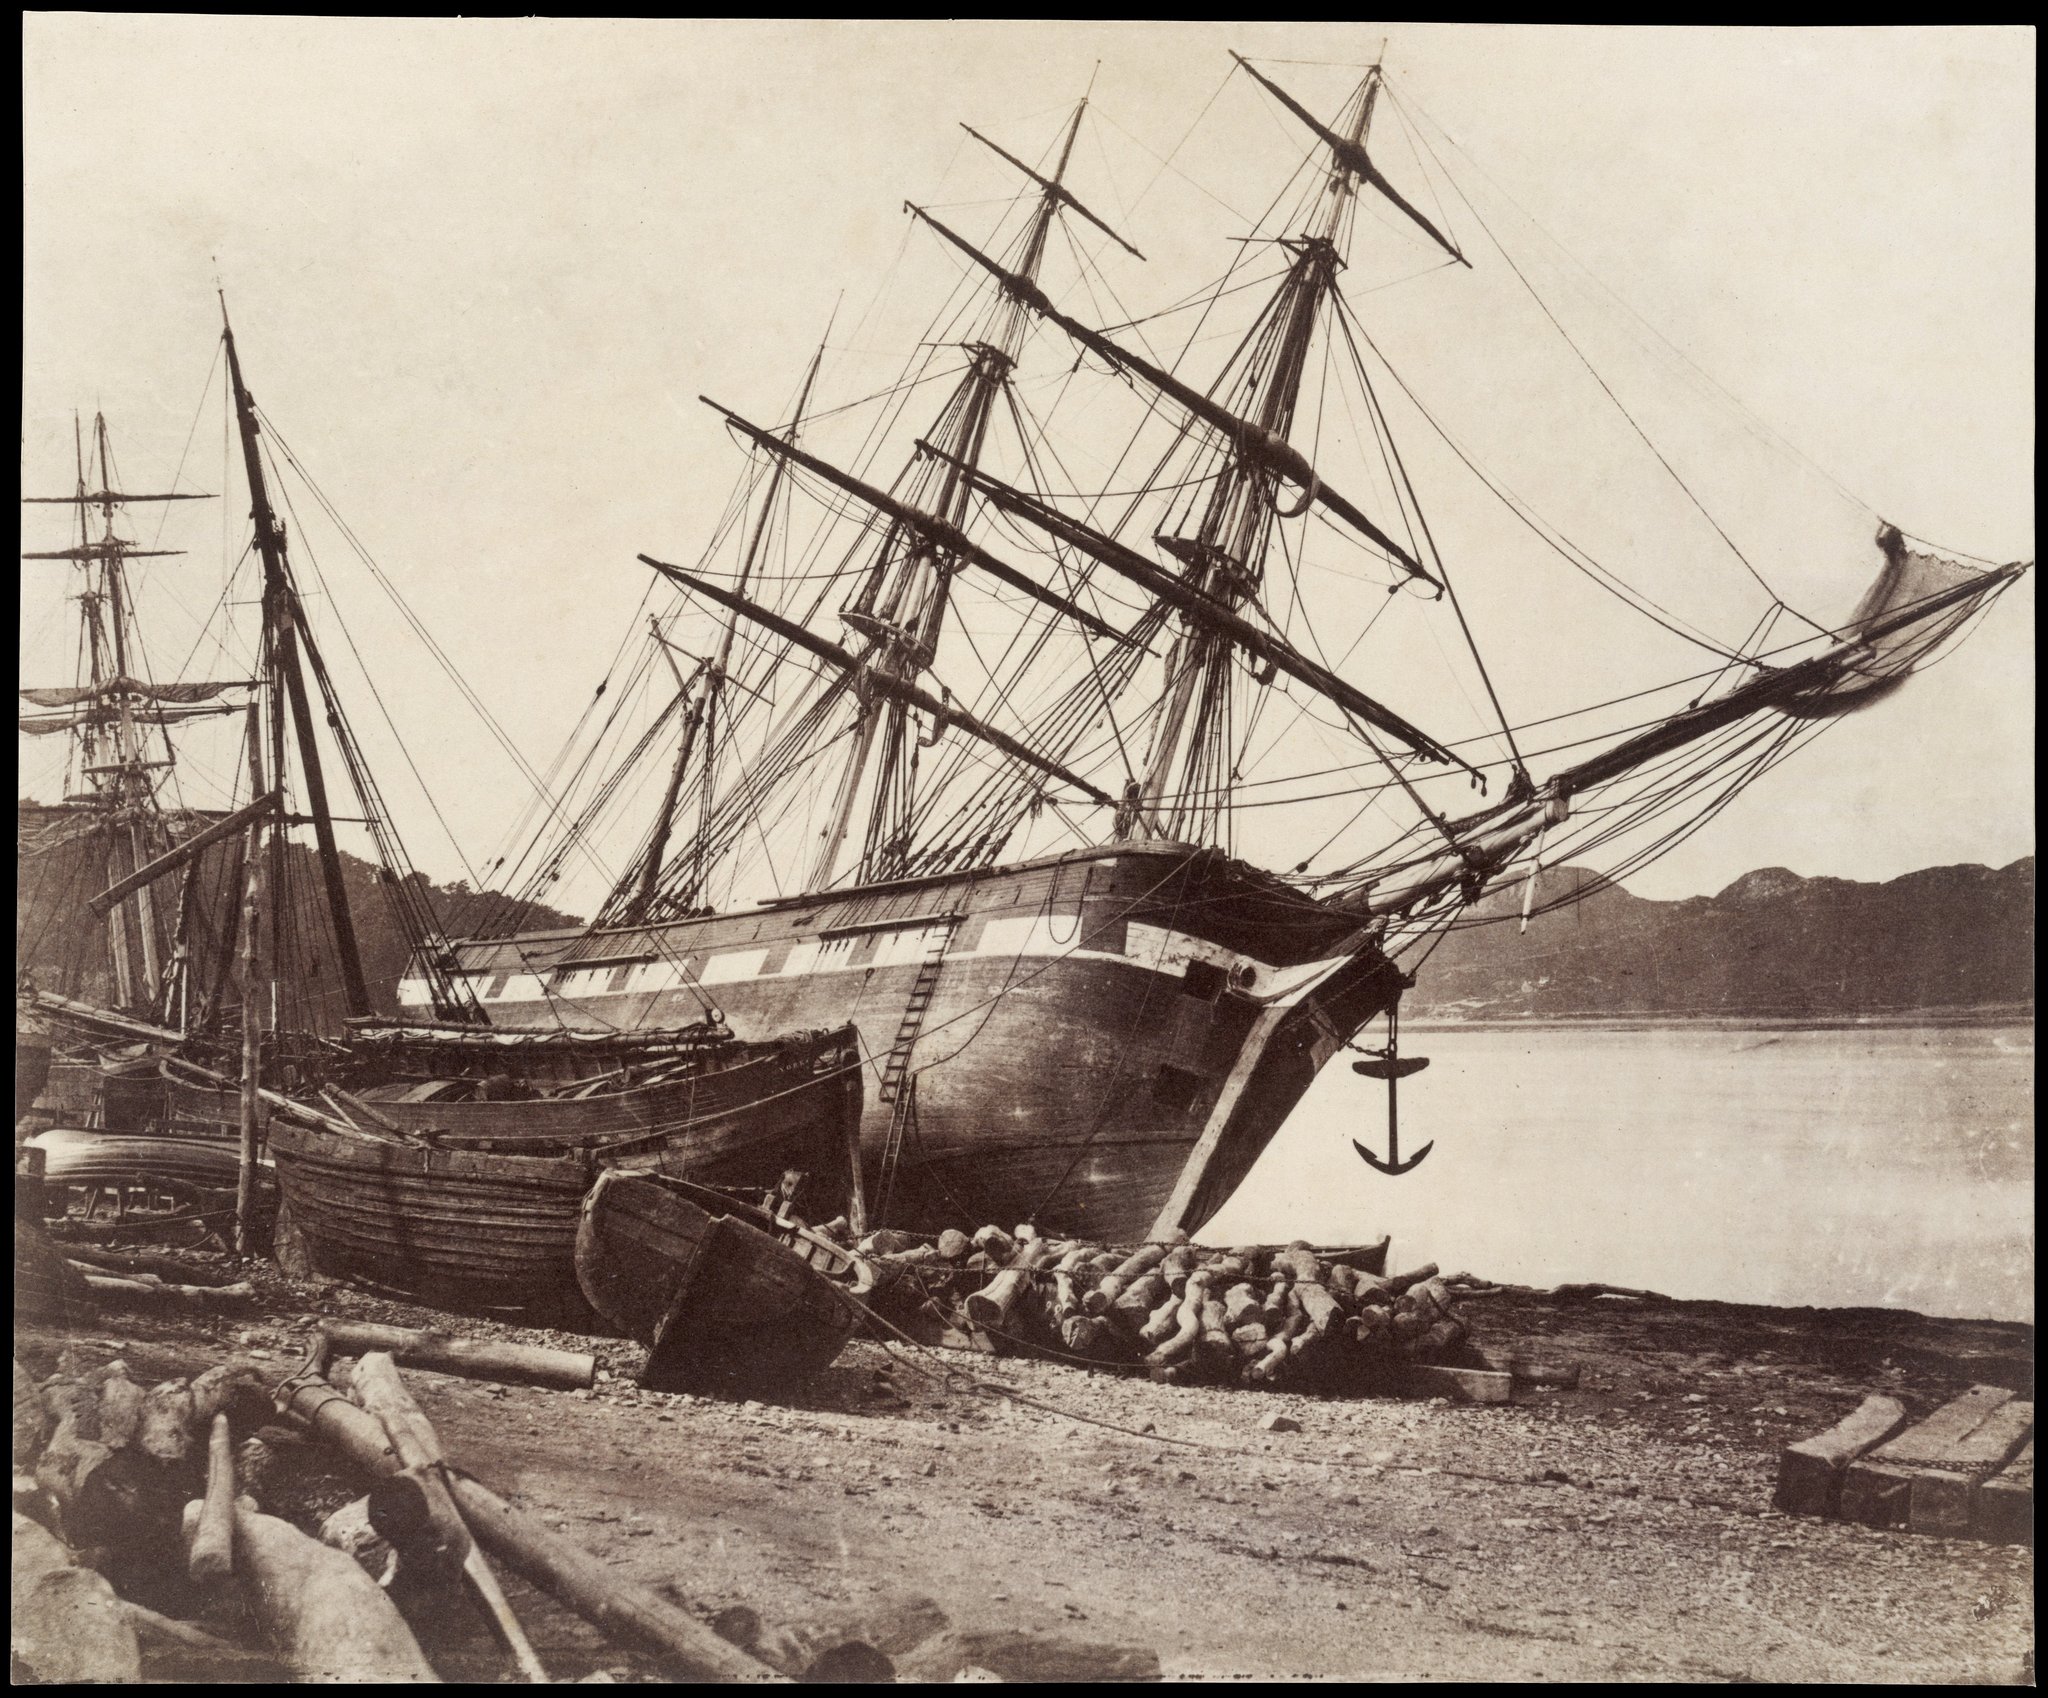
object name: photograph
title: American Barque "Jane Tudor," Conway Bay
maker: david johnson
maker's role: artist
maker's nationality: british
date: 1855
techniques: glass negative, salted paper print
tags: ships